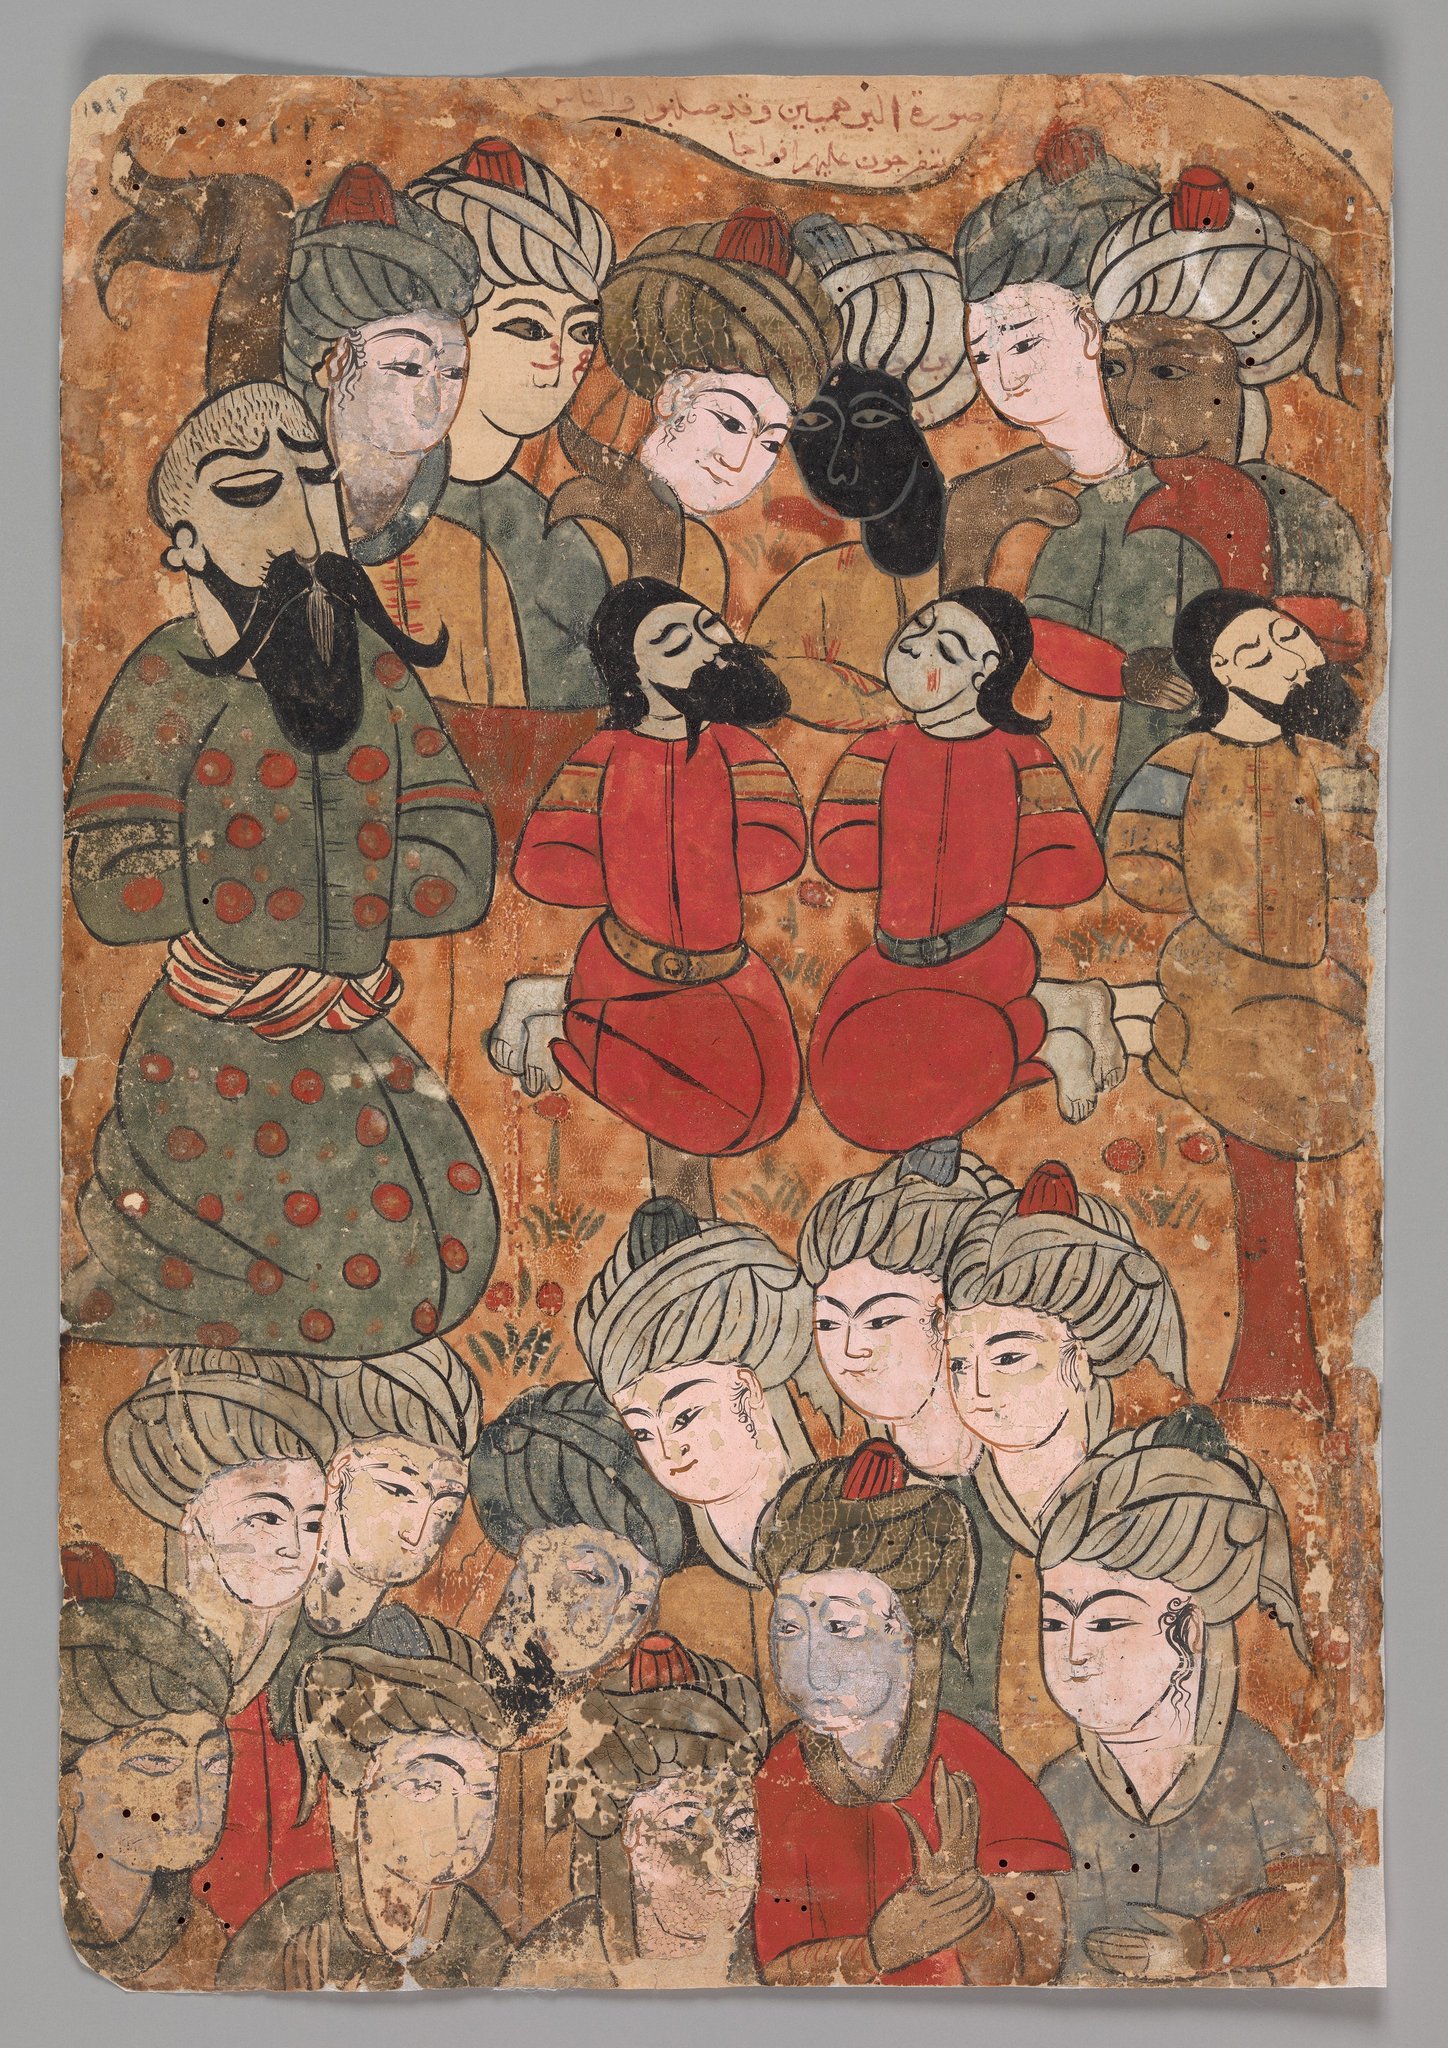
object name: folio from an illustrated manuscript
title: "The Execution of the Brahmins", Folio from a Kalila wa Dimna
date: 1526-1550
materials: ink, paper, watercolor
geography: india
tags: men